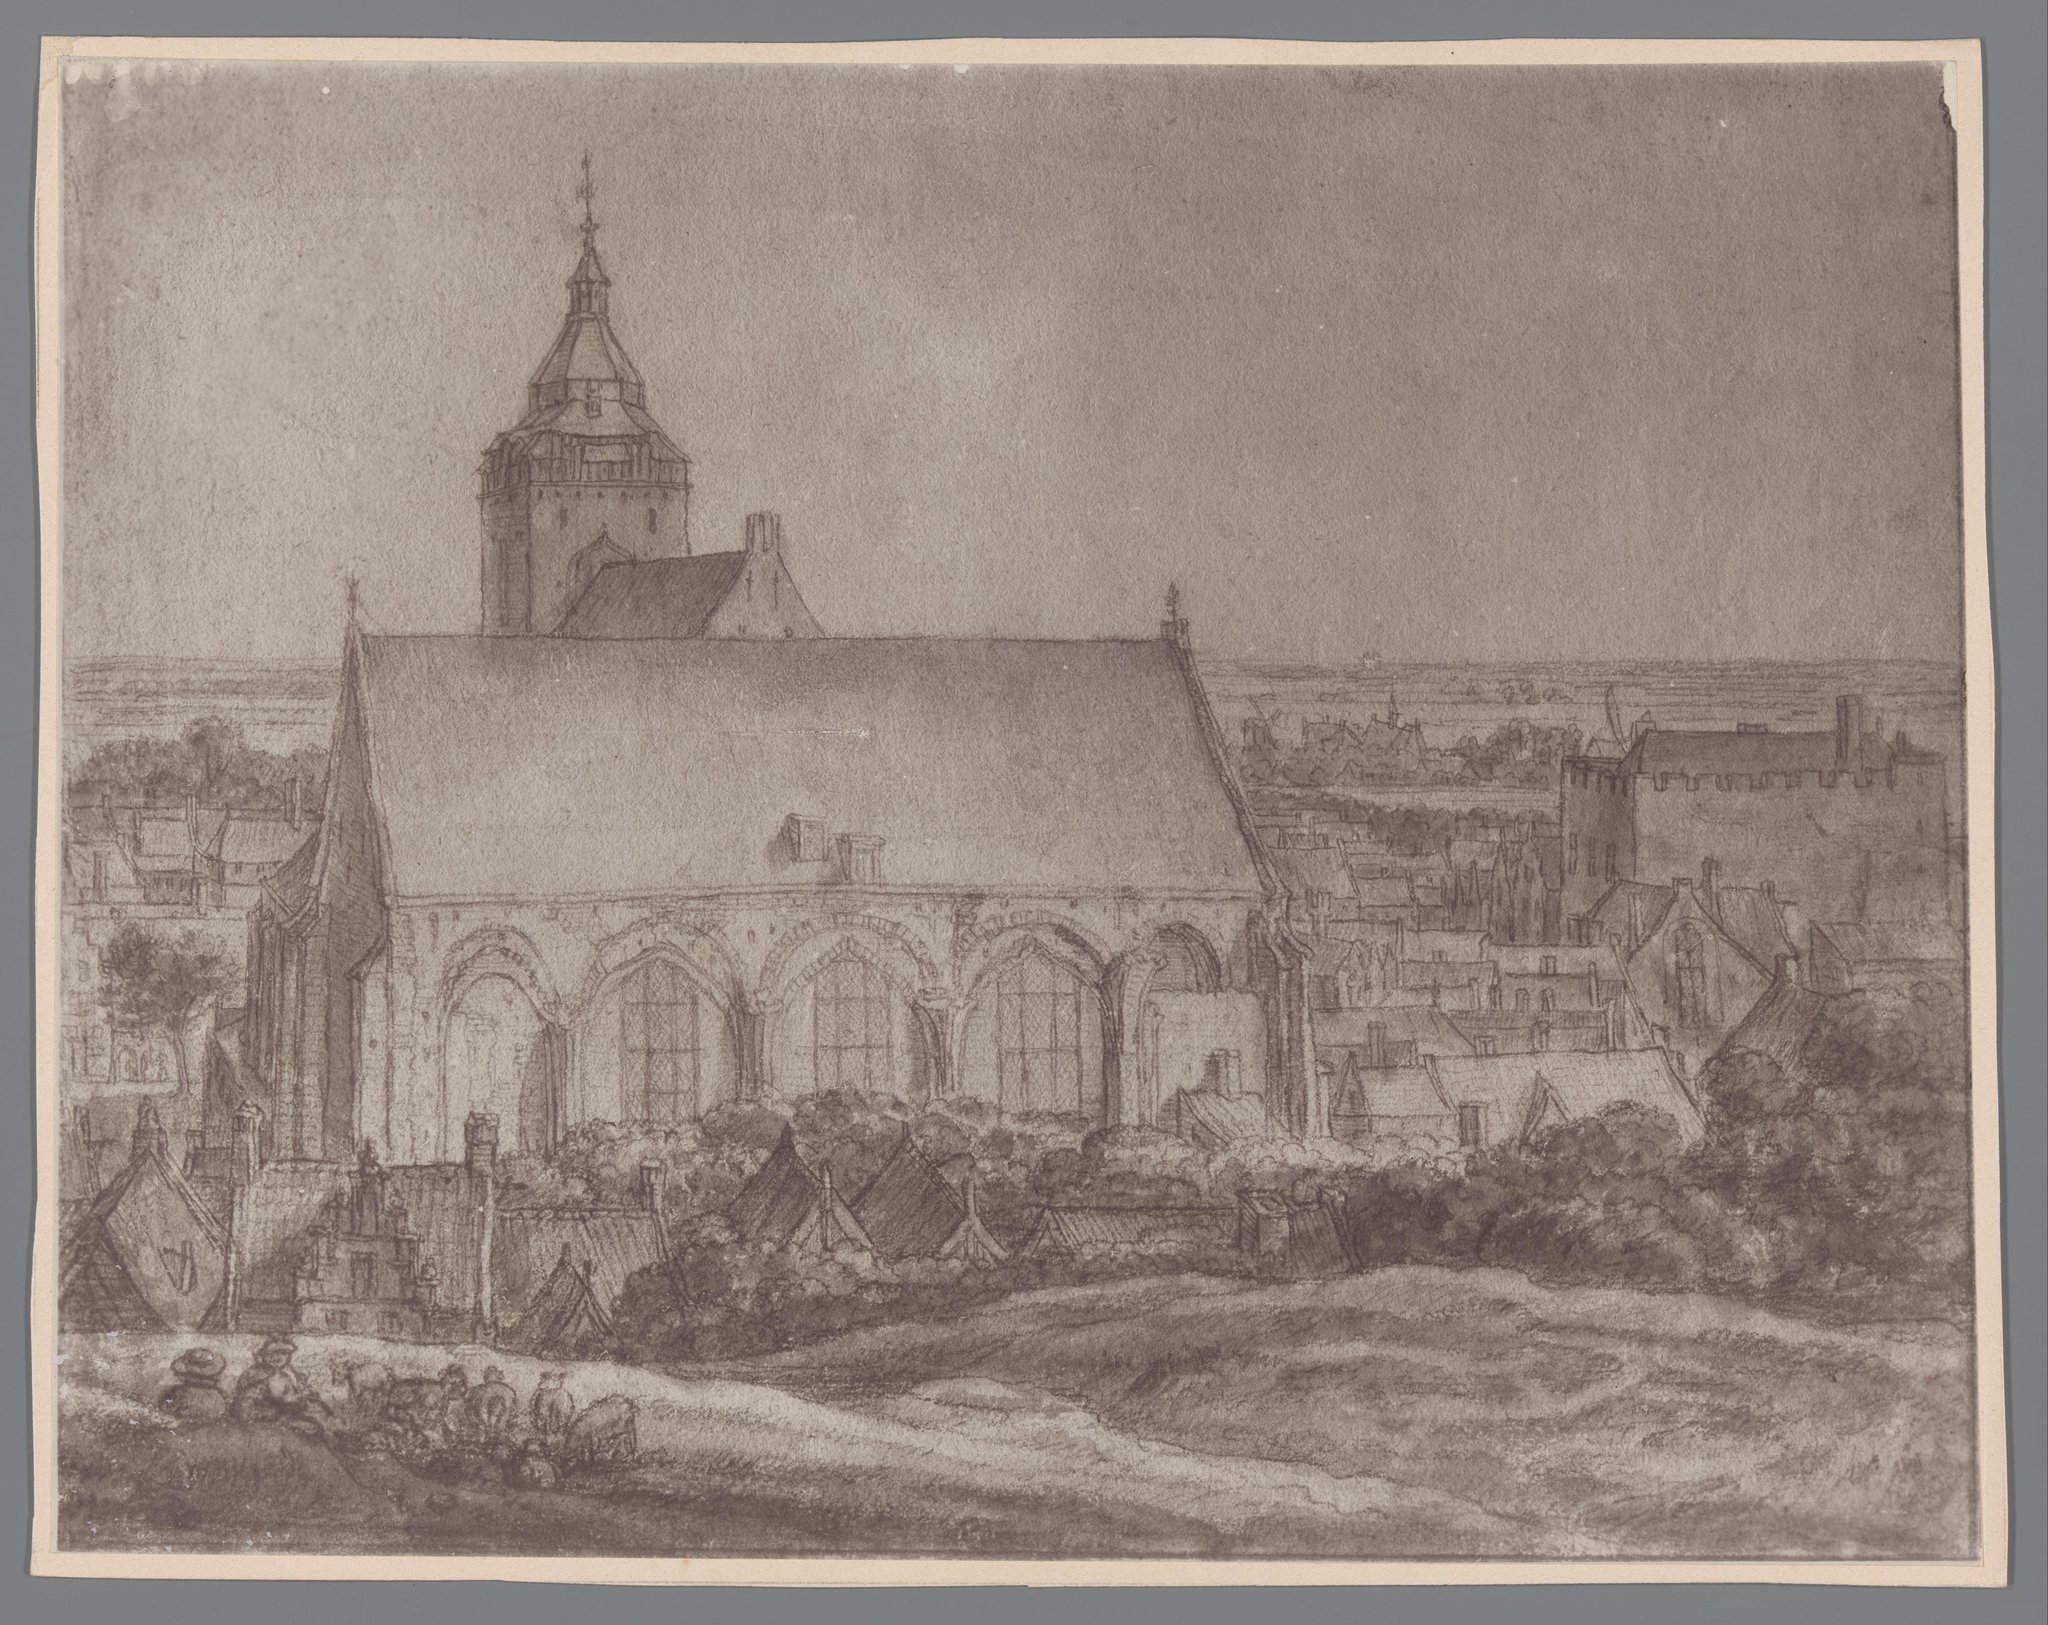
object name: photograph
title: Fotoreproductie van een tekening van een gezicht op de Buurkerk te Utrecht door Anthonie Waterloo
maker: Anonymous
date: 1880-1907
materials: cardboard, photographic support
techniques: collodion silver print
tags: church (exterior), city-view in general; 'veduta' (+ city(-scape) with figures, staffage)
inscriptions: annotation: ‘Muller 86/ [(supplement 1907)]/ (op andere helft Mariakerk)/ Buurkerk/ Waterloo del./ Buurkerk te Utrecht/ AA.506’